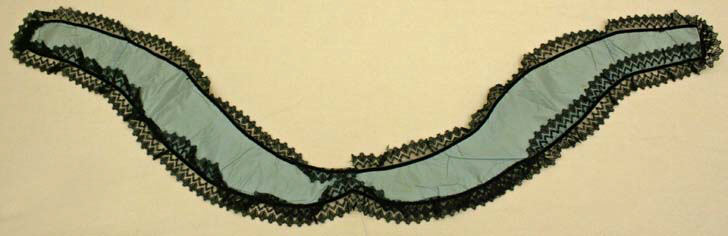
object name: collar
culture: american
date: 1700-1937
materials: silk